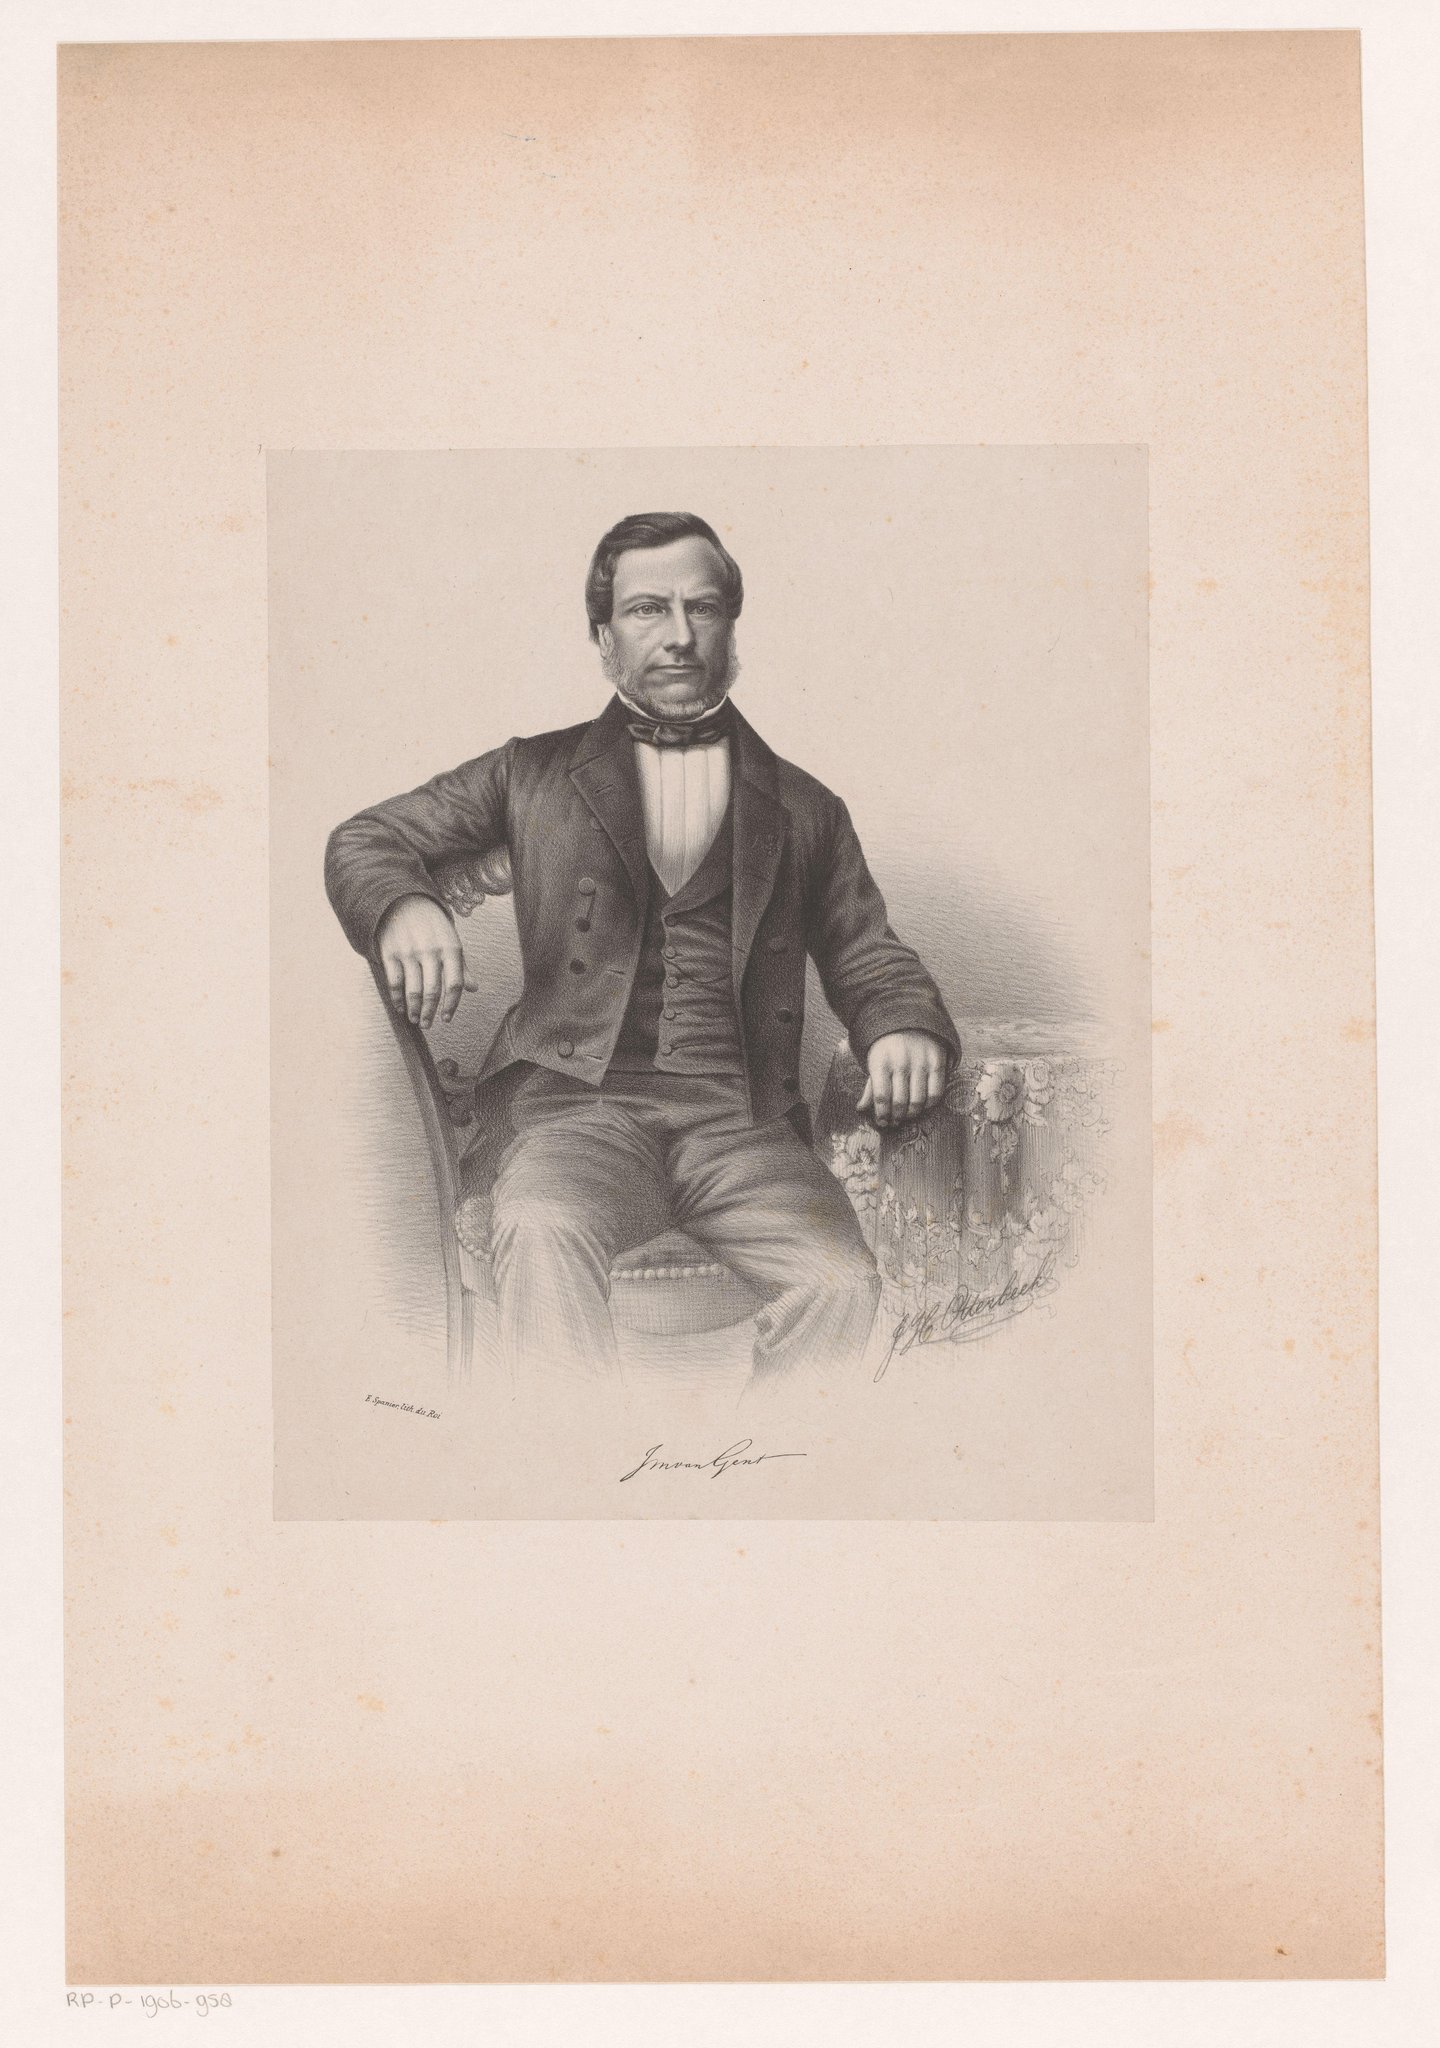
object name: print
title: Portret van J.M. (Jacobus Marinus) van Gent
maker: elias spanier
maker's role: print maker, printer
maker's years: 1821-1863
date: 1849-1863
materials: paper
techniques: lithograph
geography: the hague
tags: historical persons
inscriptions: collector's mark: Lugt 2228